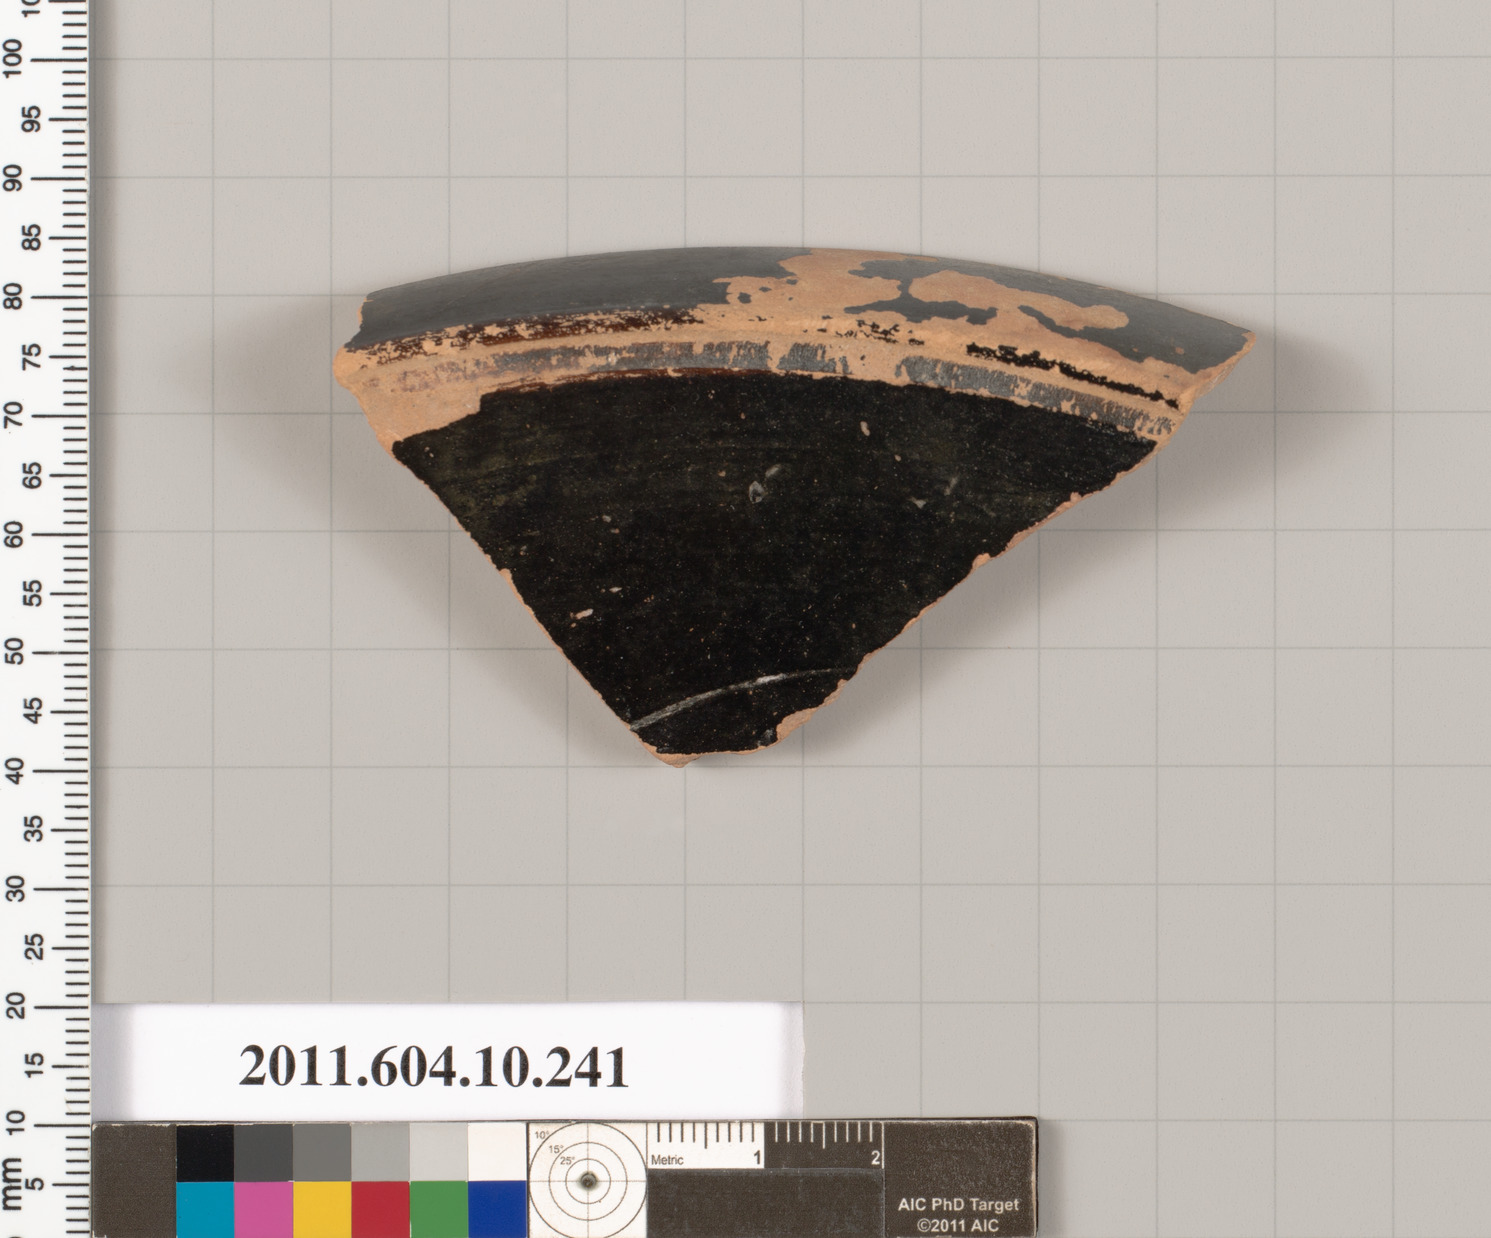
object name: plate fragment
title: Terracotta fragment of a "fish plate"?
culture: etruscan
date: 400-201 BCE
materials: terracotta